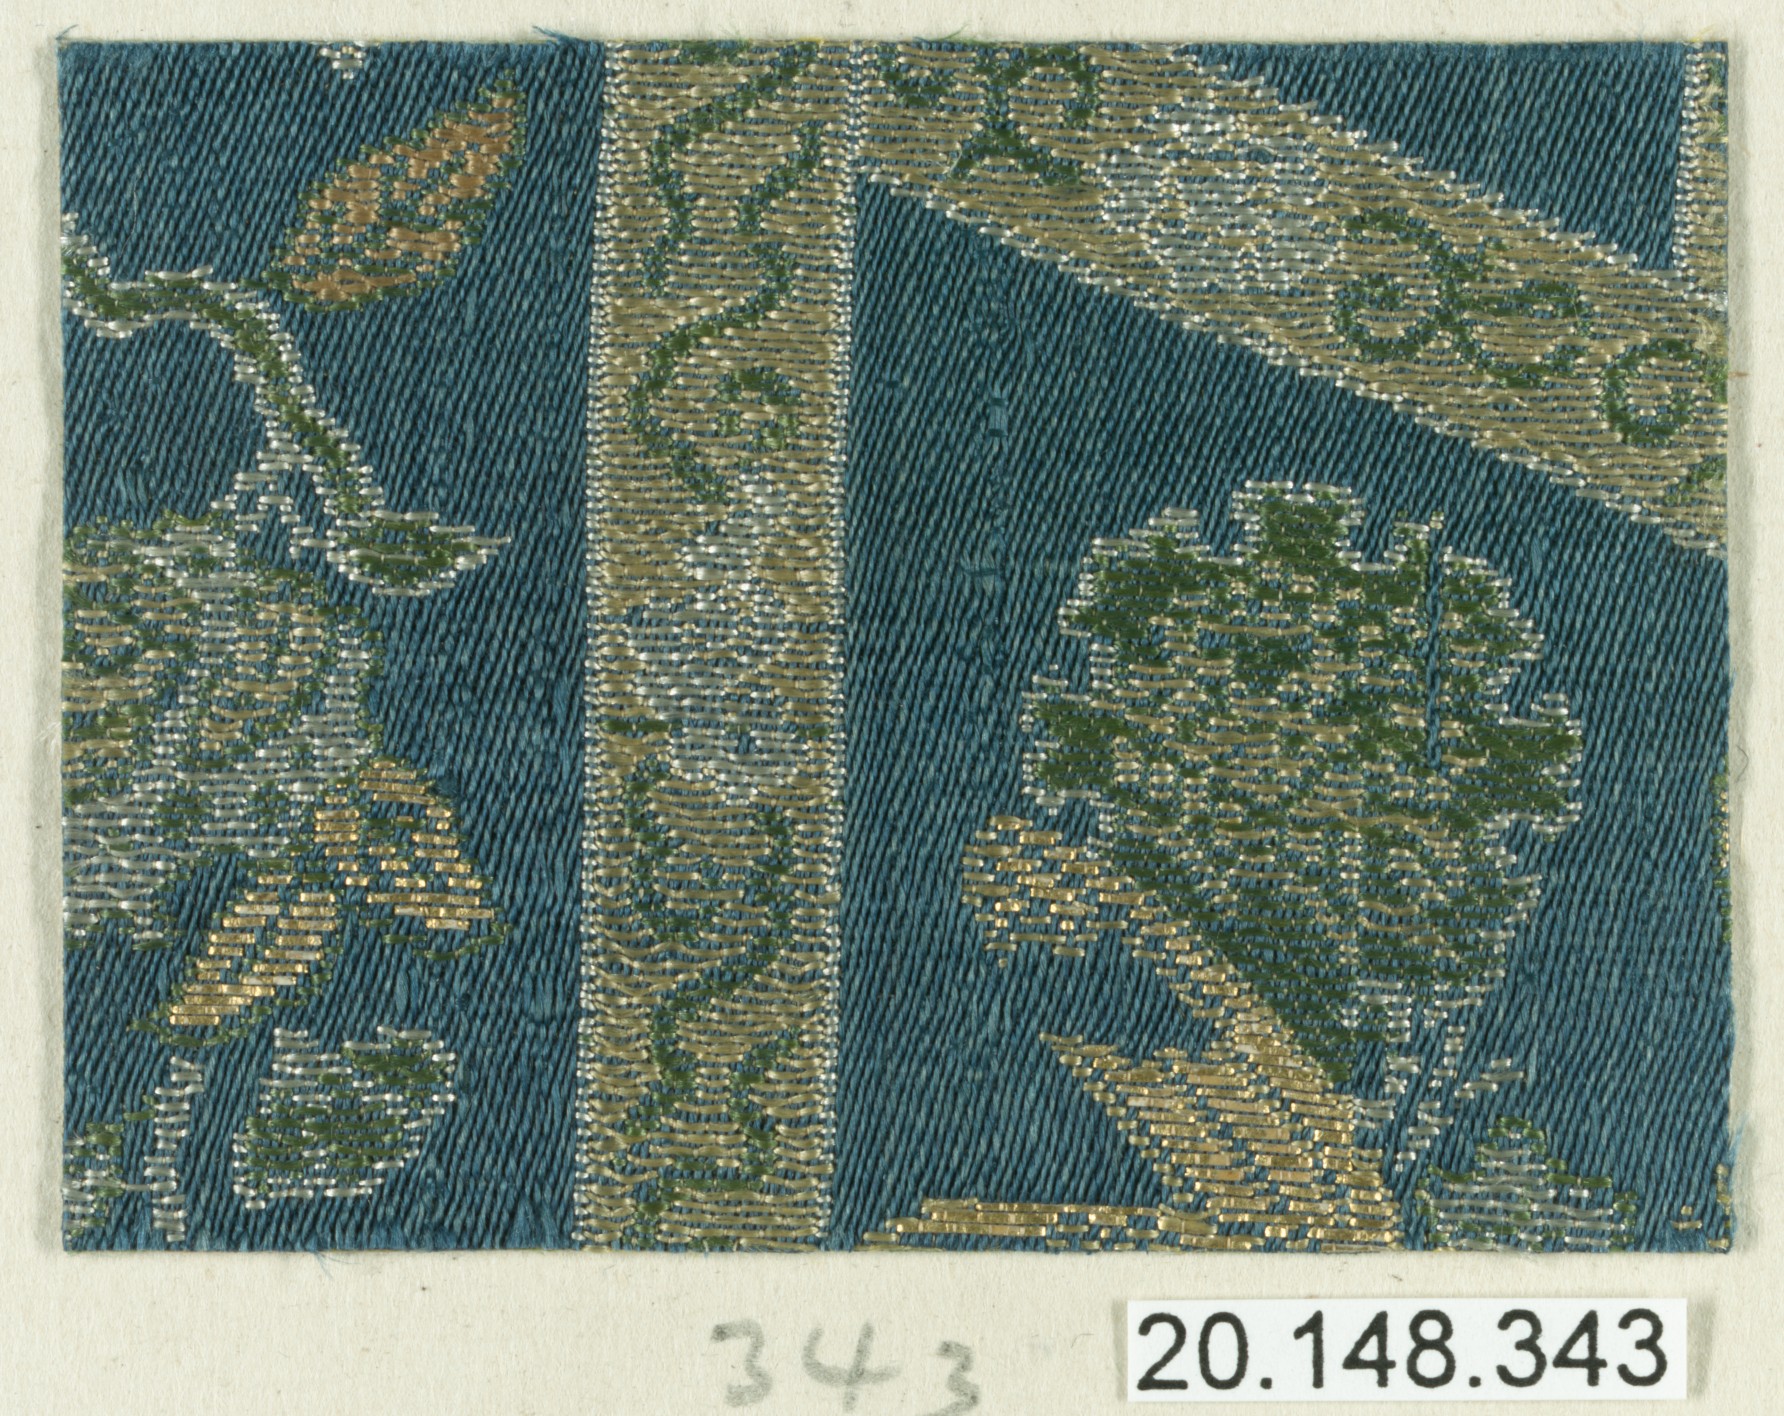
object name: piece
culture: chinese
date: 1601-1700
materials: silk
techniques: compound weave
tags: leaves